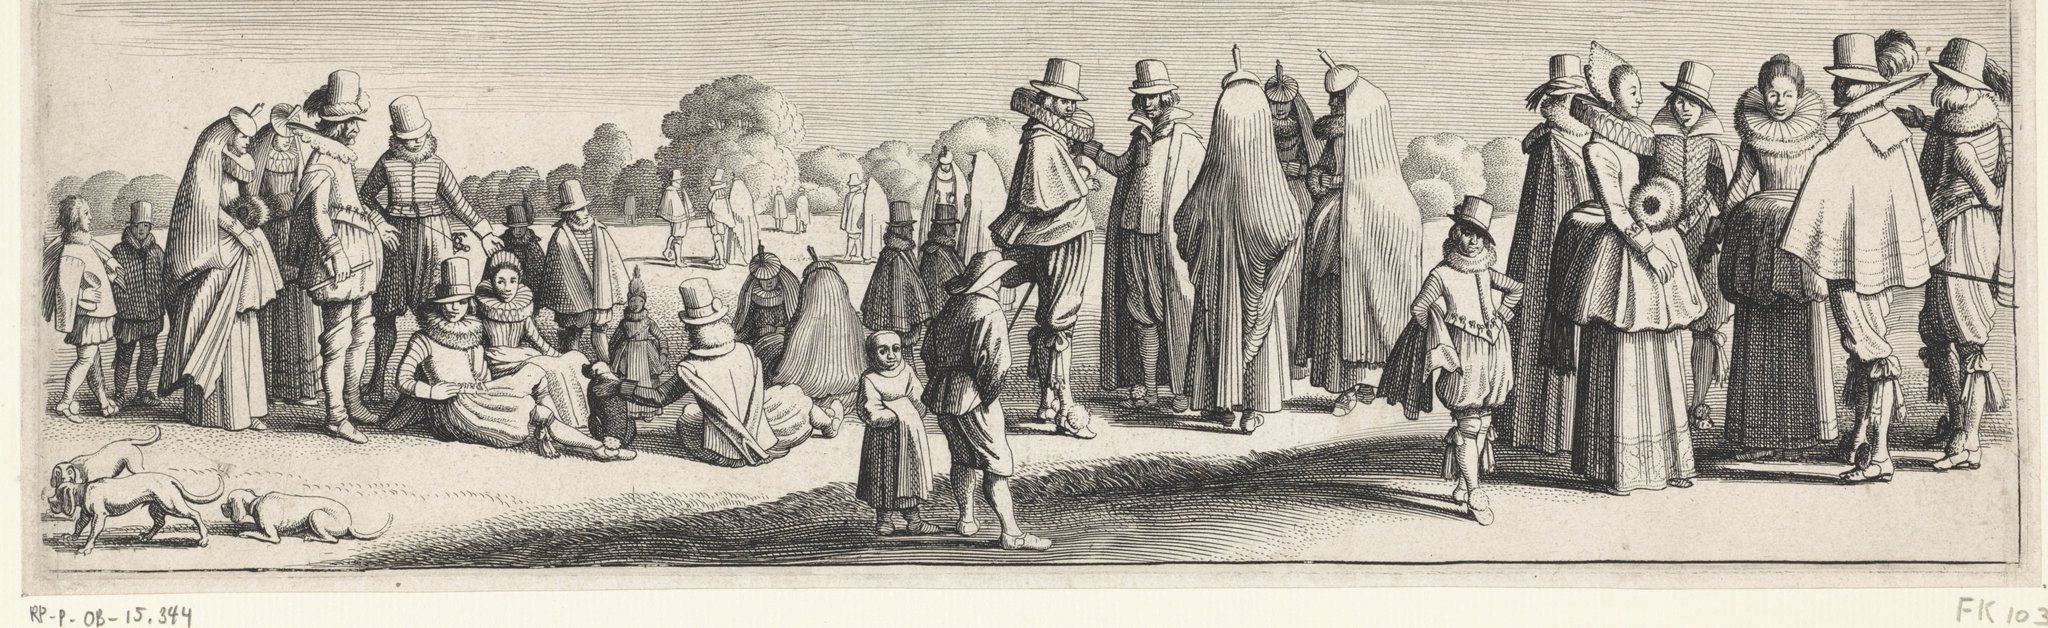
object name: print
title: Staande en zittende elegante paren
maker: jan van de velde (ii)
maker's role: draughtsman, painter, print maker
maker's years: 1593-1641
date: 1603-1633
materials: paper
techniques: engraving, etching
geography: northern netherlands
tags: cape (huik) (+ women's clothes), open-air recreation, market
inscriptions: collector's mark: Lugt 240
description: Enkele figuren gekopiëerd door Abraham Goos in de rand van de kaart 'Comitatus Hollandia' uit 1633, uitgegeven door Claes Jansz. Visscher II (niet in Hollst). Zie cat. Kunst in Kaart, Amsterdam, RPK, 1989, pp. 53-54. Object samen geëncadreerd met RP-P-OB-15.343 derde prent uit de serie.